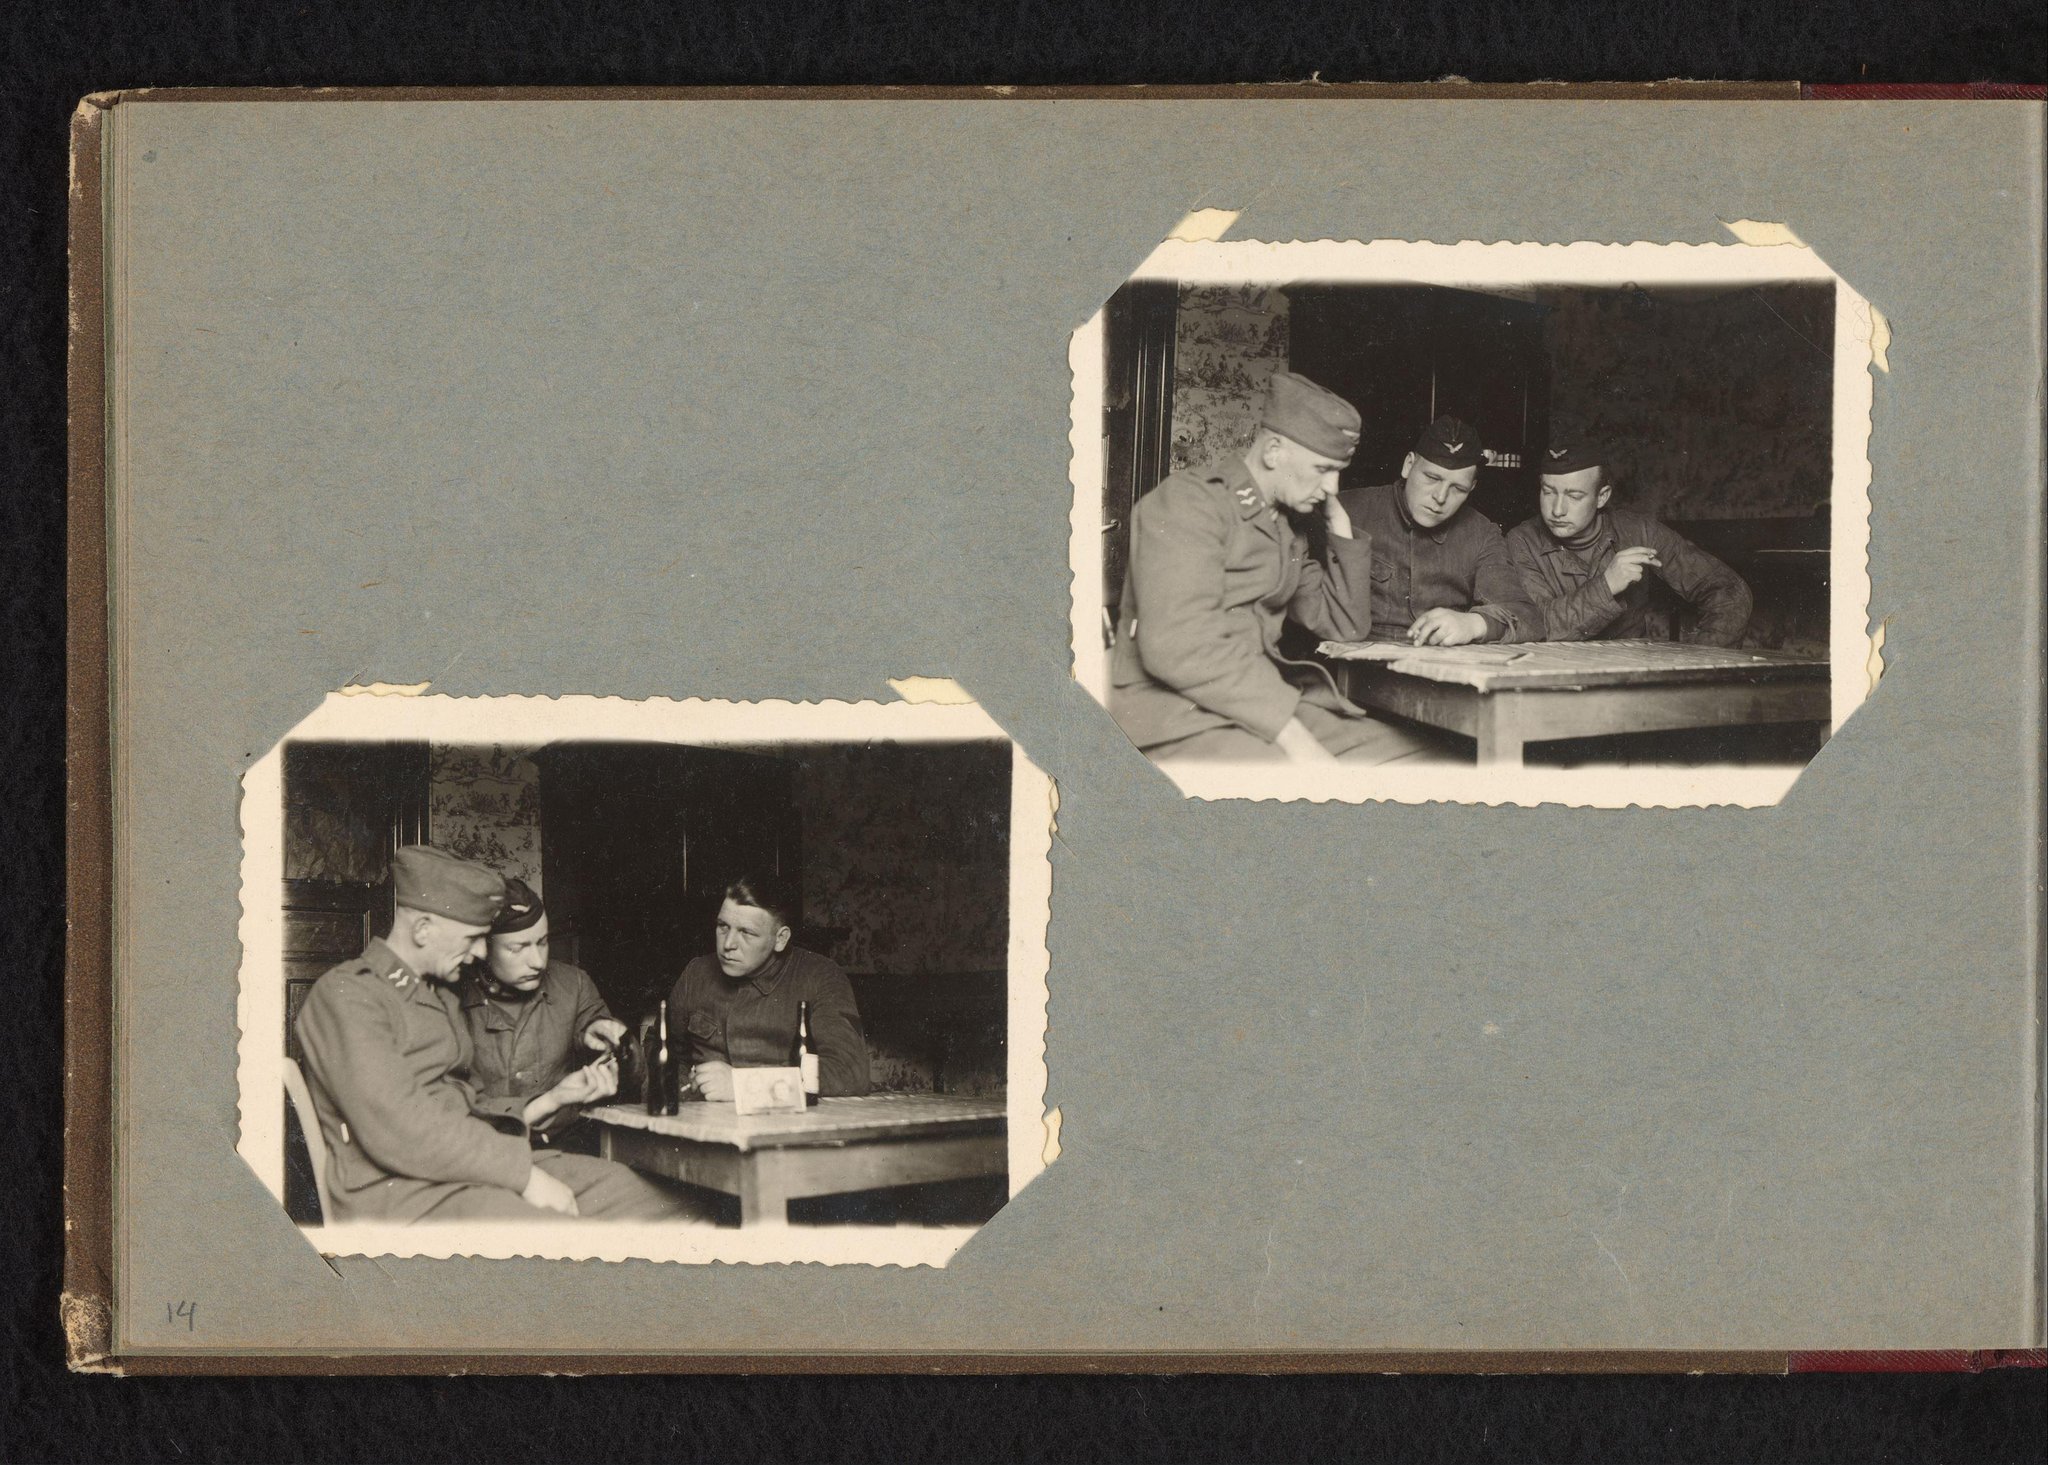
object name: album leaf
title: Duitse militairen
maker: Anonymous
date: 1940-1945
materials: paper, photographic support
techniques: gelatin silver print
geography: germany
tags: the company, the unit, the troop ~ military service, the soldier off duty, germany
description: Albumblad met twee foto's van Duitse militairen aan een tafel. Onderdeel van een fotoalbum over de diensttijd van Dieter Glitsch uit Hardegsen tijdens de Tweede Wereldoorlog en de jaren daarna.